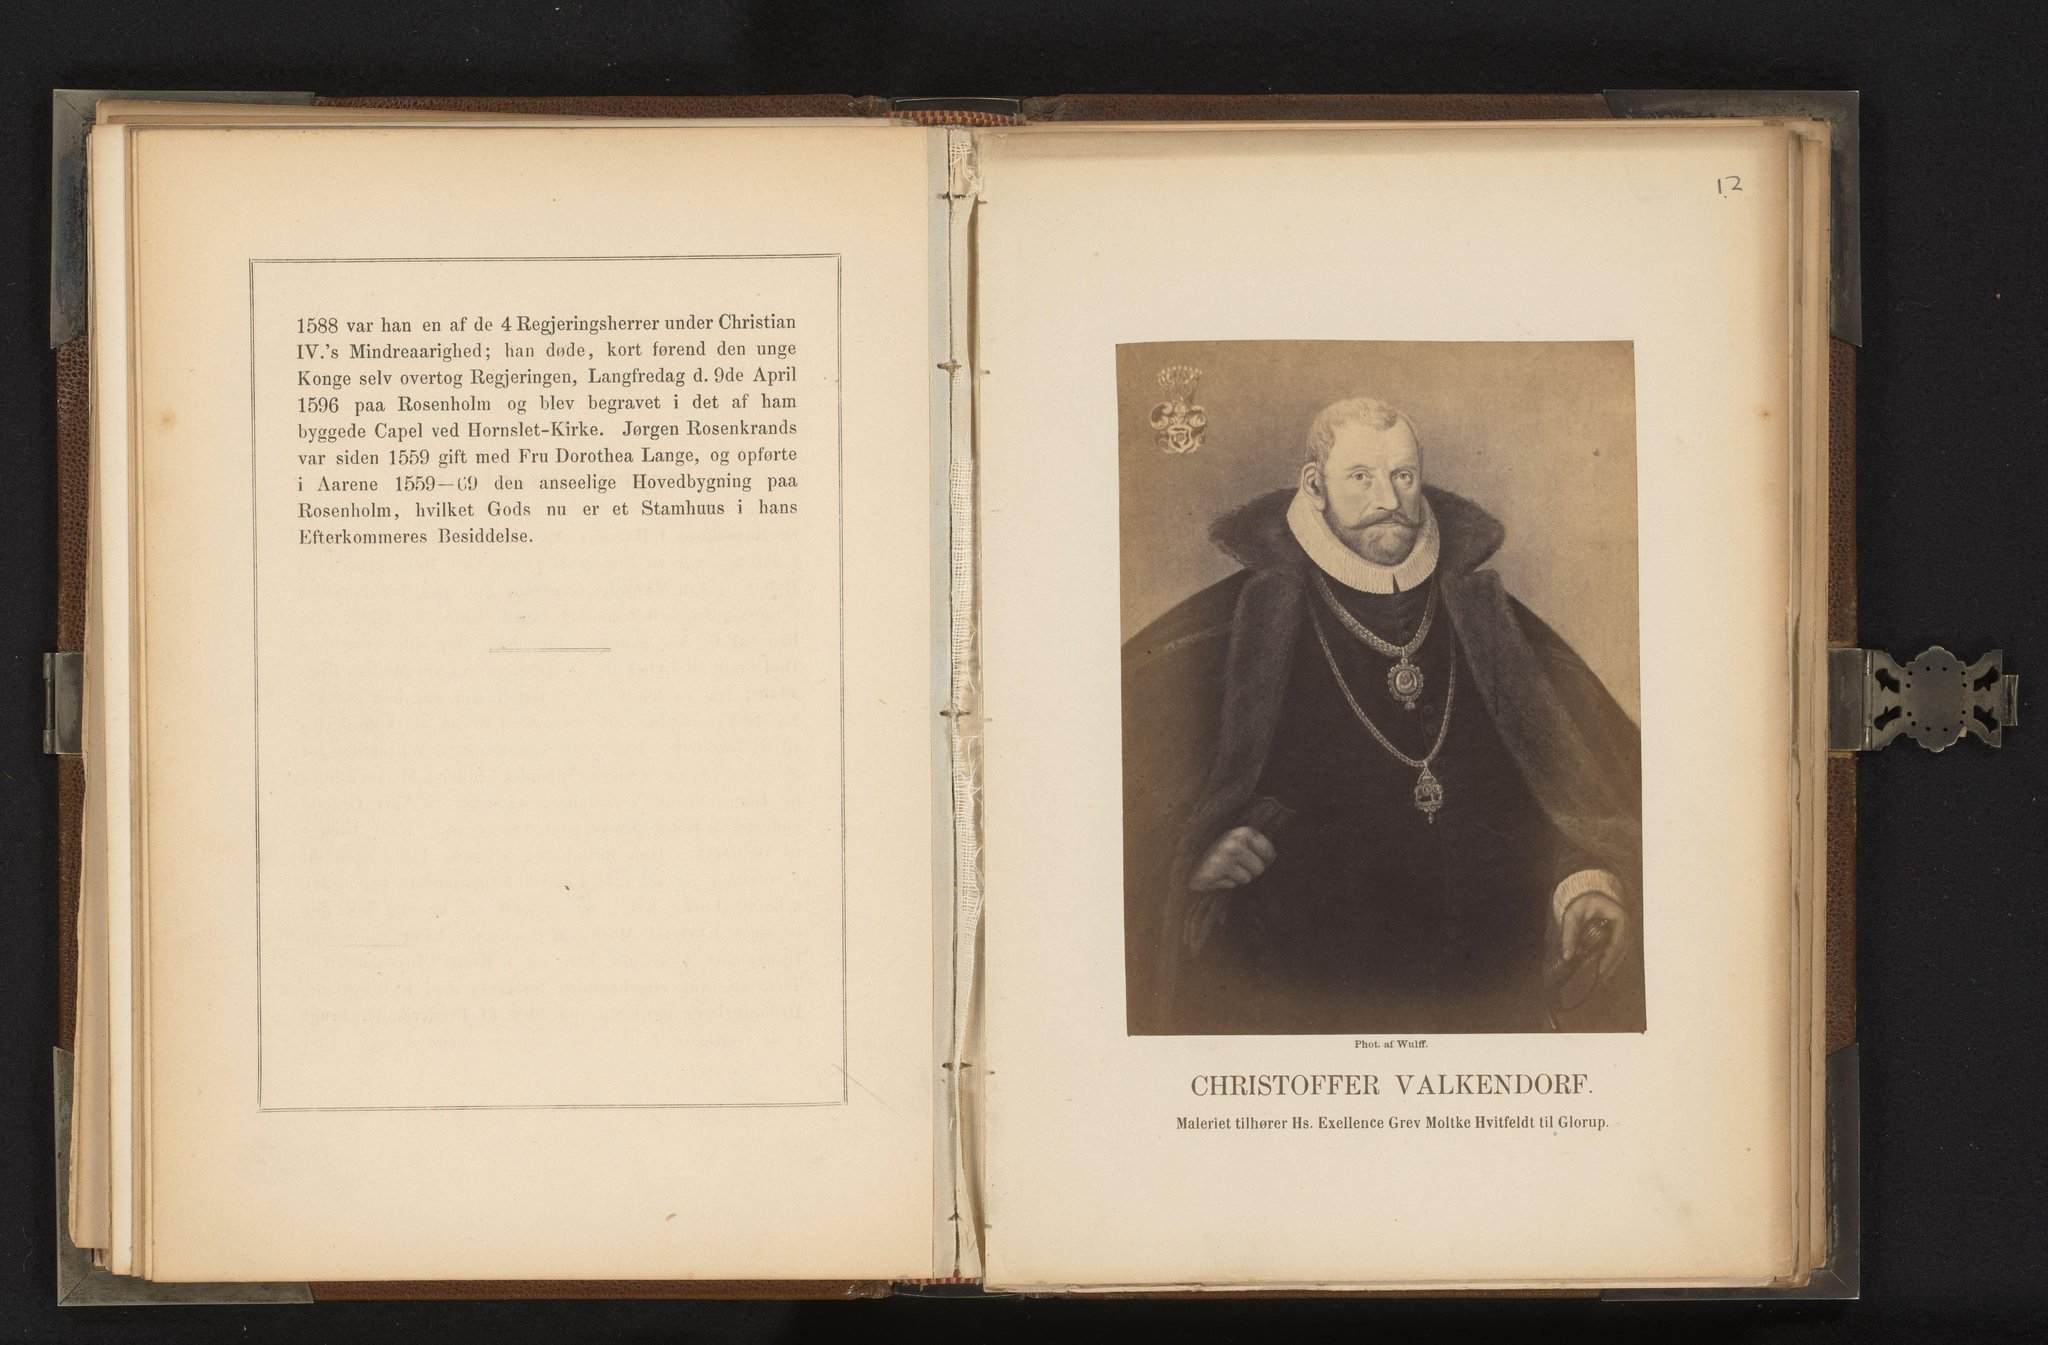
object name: reproduction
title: Fotoreproductie van een schilderij, voorstellende een portret van Christoffer Valkendorff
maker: julius wulff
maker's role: fotograaf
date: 1858-1863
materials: photographic support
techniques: albumen print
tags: official; civil servant; functionary (in general)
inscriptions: inscription: ‘Maleriet tillhører Hs. Exellence Grev Moltke Hvitfeldt til Glorup.’